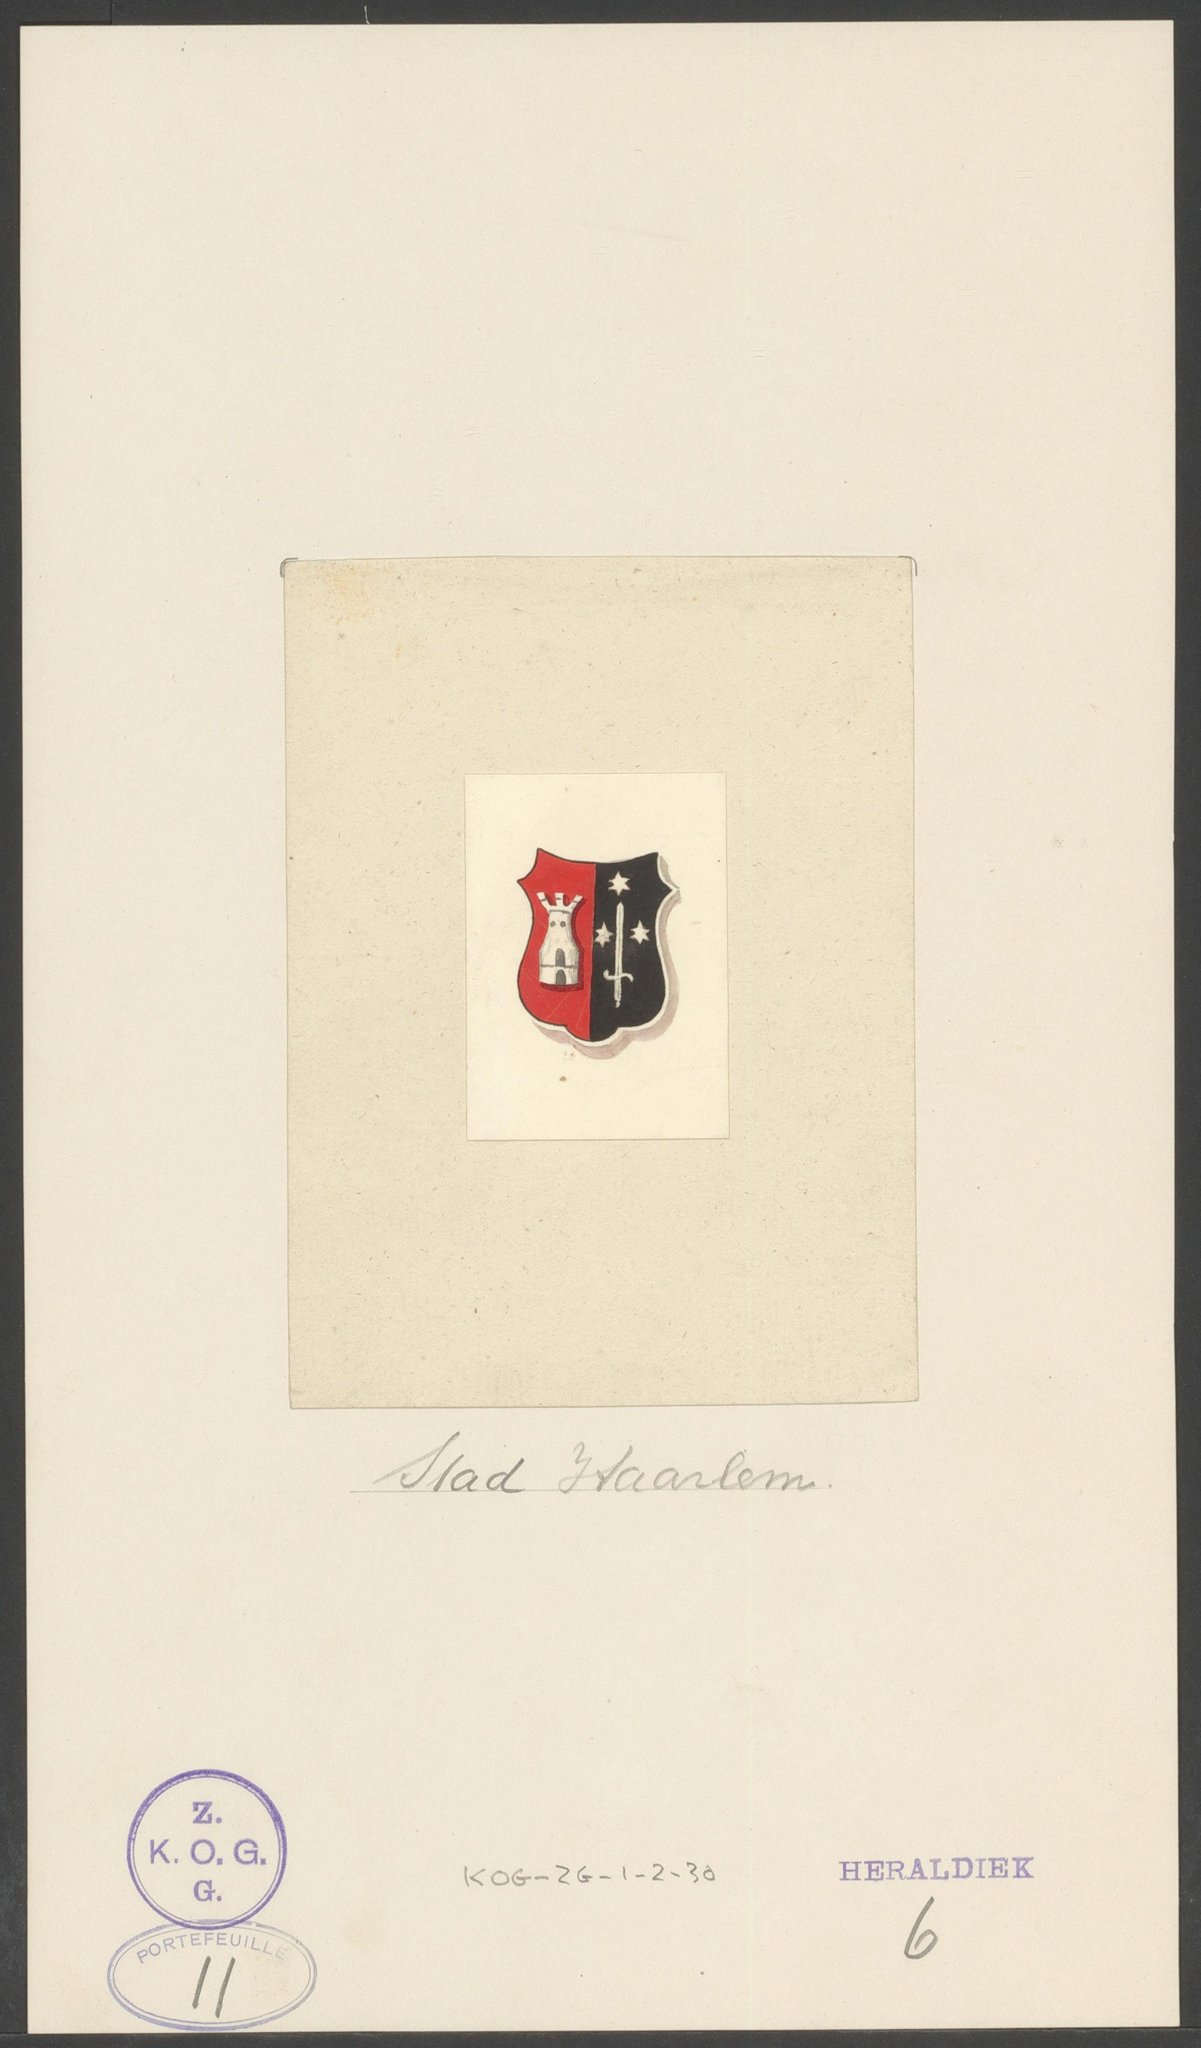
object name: drawing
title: Wapen van Haarlem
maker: Anonymous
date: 1800-1900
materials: paper, watercolor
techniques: brush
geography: netherlands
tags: coat of arms (as symbol of the state, etc.) (+ city; municipal), 'tropaion', i.e. decorative ornament ~ weapons, haarlem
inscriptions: collector's mark: Lugt 1641, collector's mark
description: Stadswapen van Haarlem. Gedeeld schild met links de toren van Damiate en rechts het zwaard met drie sterren. Onderwerpsrubrieken binnen de Atlas Zeden en Gewoonten: Regeering, Wapens, Heraldiek, Steden.